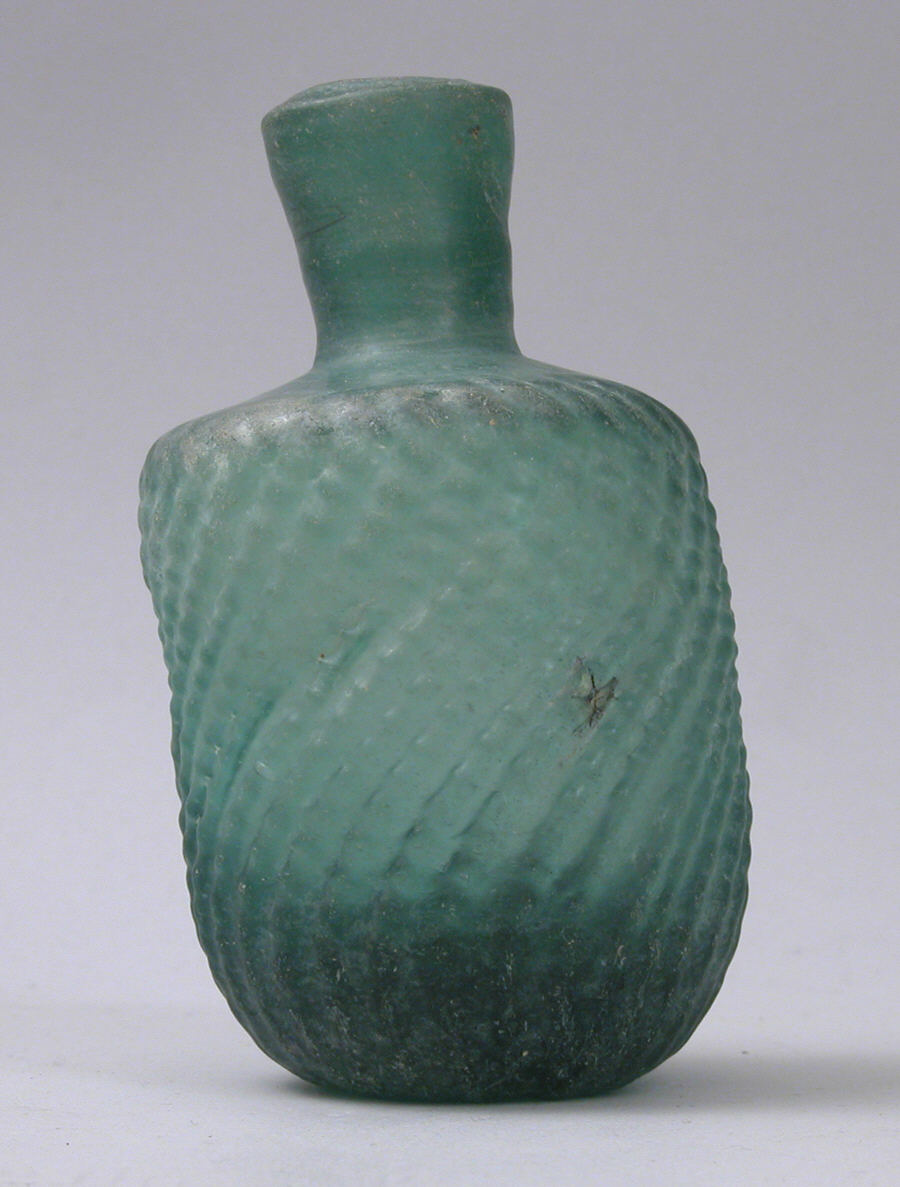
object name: bottle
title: Bottle with Twisted Ribbing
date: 901-1100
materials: glass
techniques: glassblowing, molding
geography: central asia